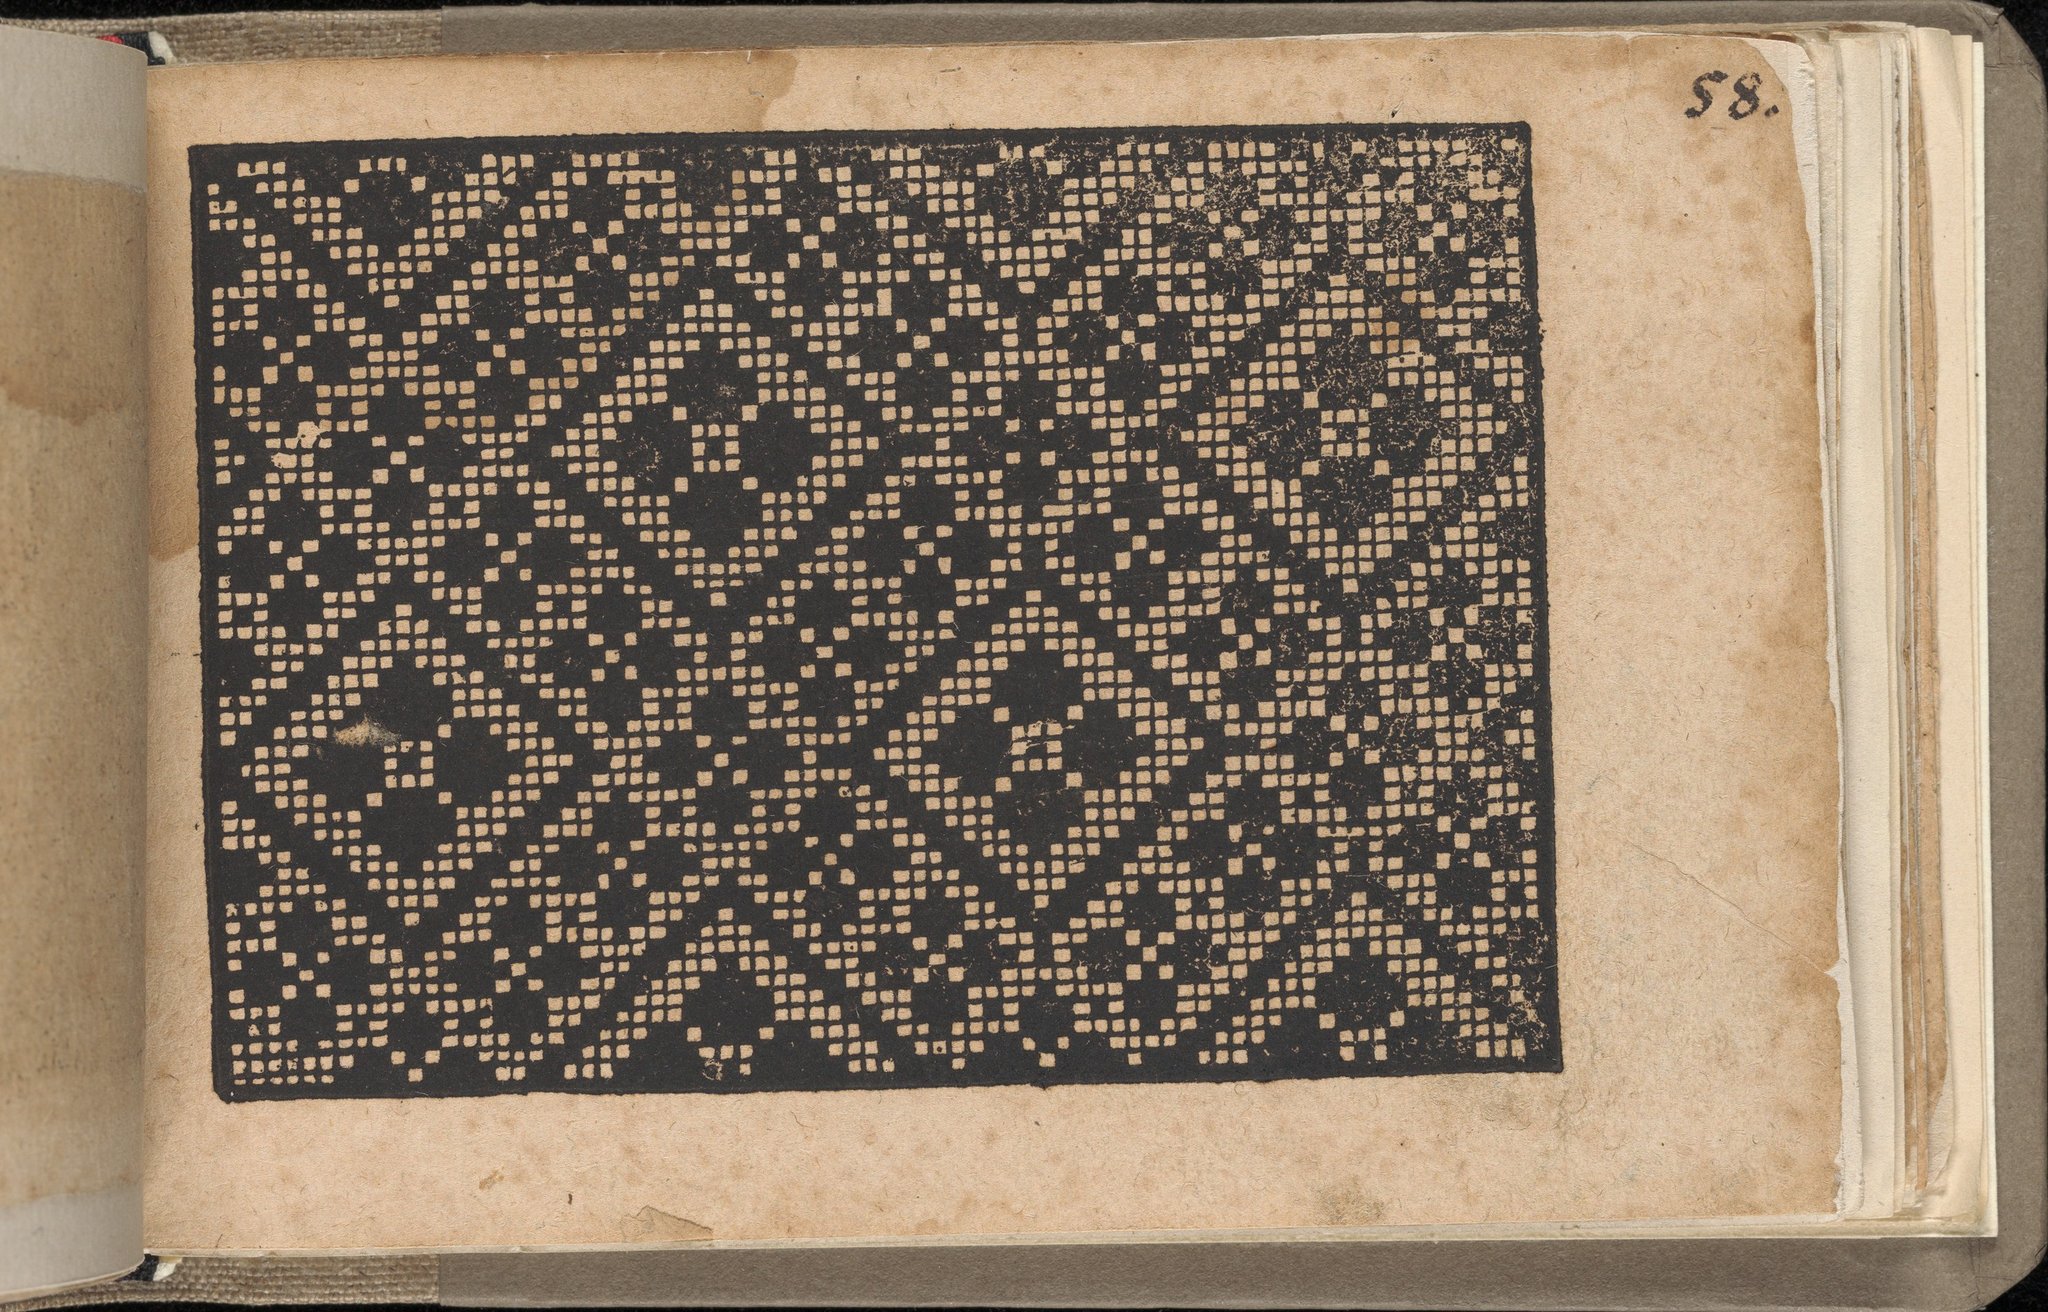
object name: book print ornament architecture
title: Schön newes Modelbuch (Page 58r)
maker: sigismundus latomus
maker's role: publisher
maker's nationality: german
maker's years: 1599-1632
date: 1608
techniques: woodcut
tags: ornament